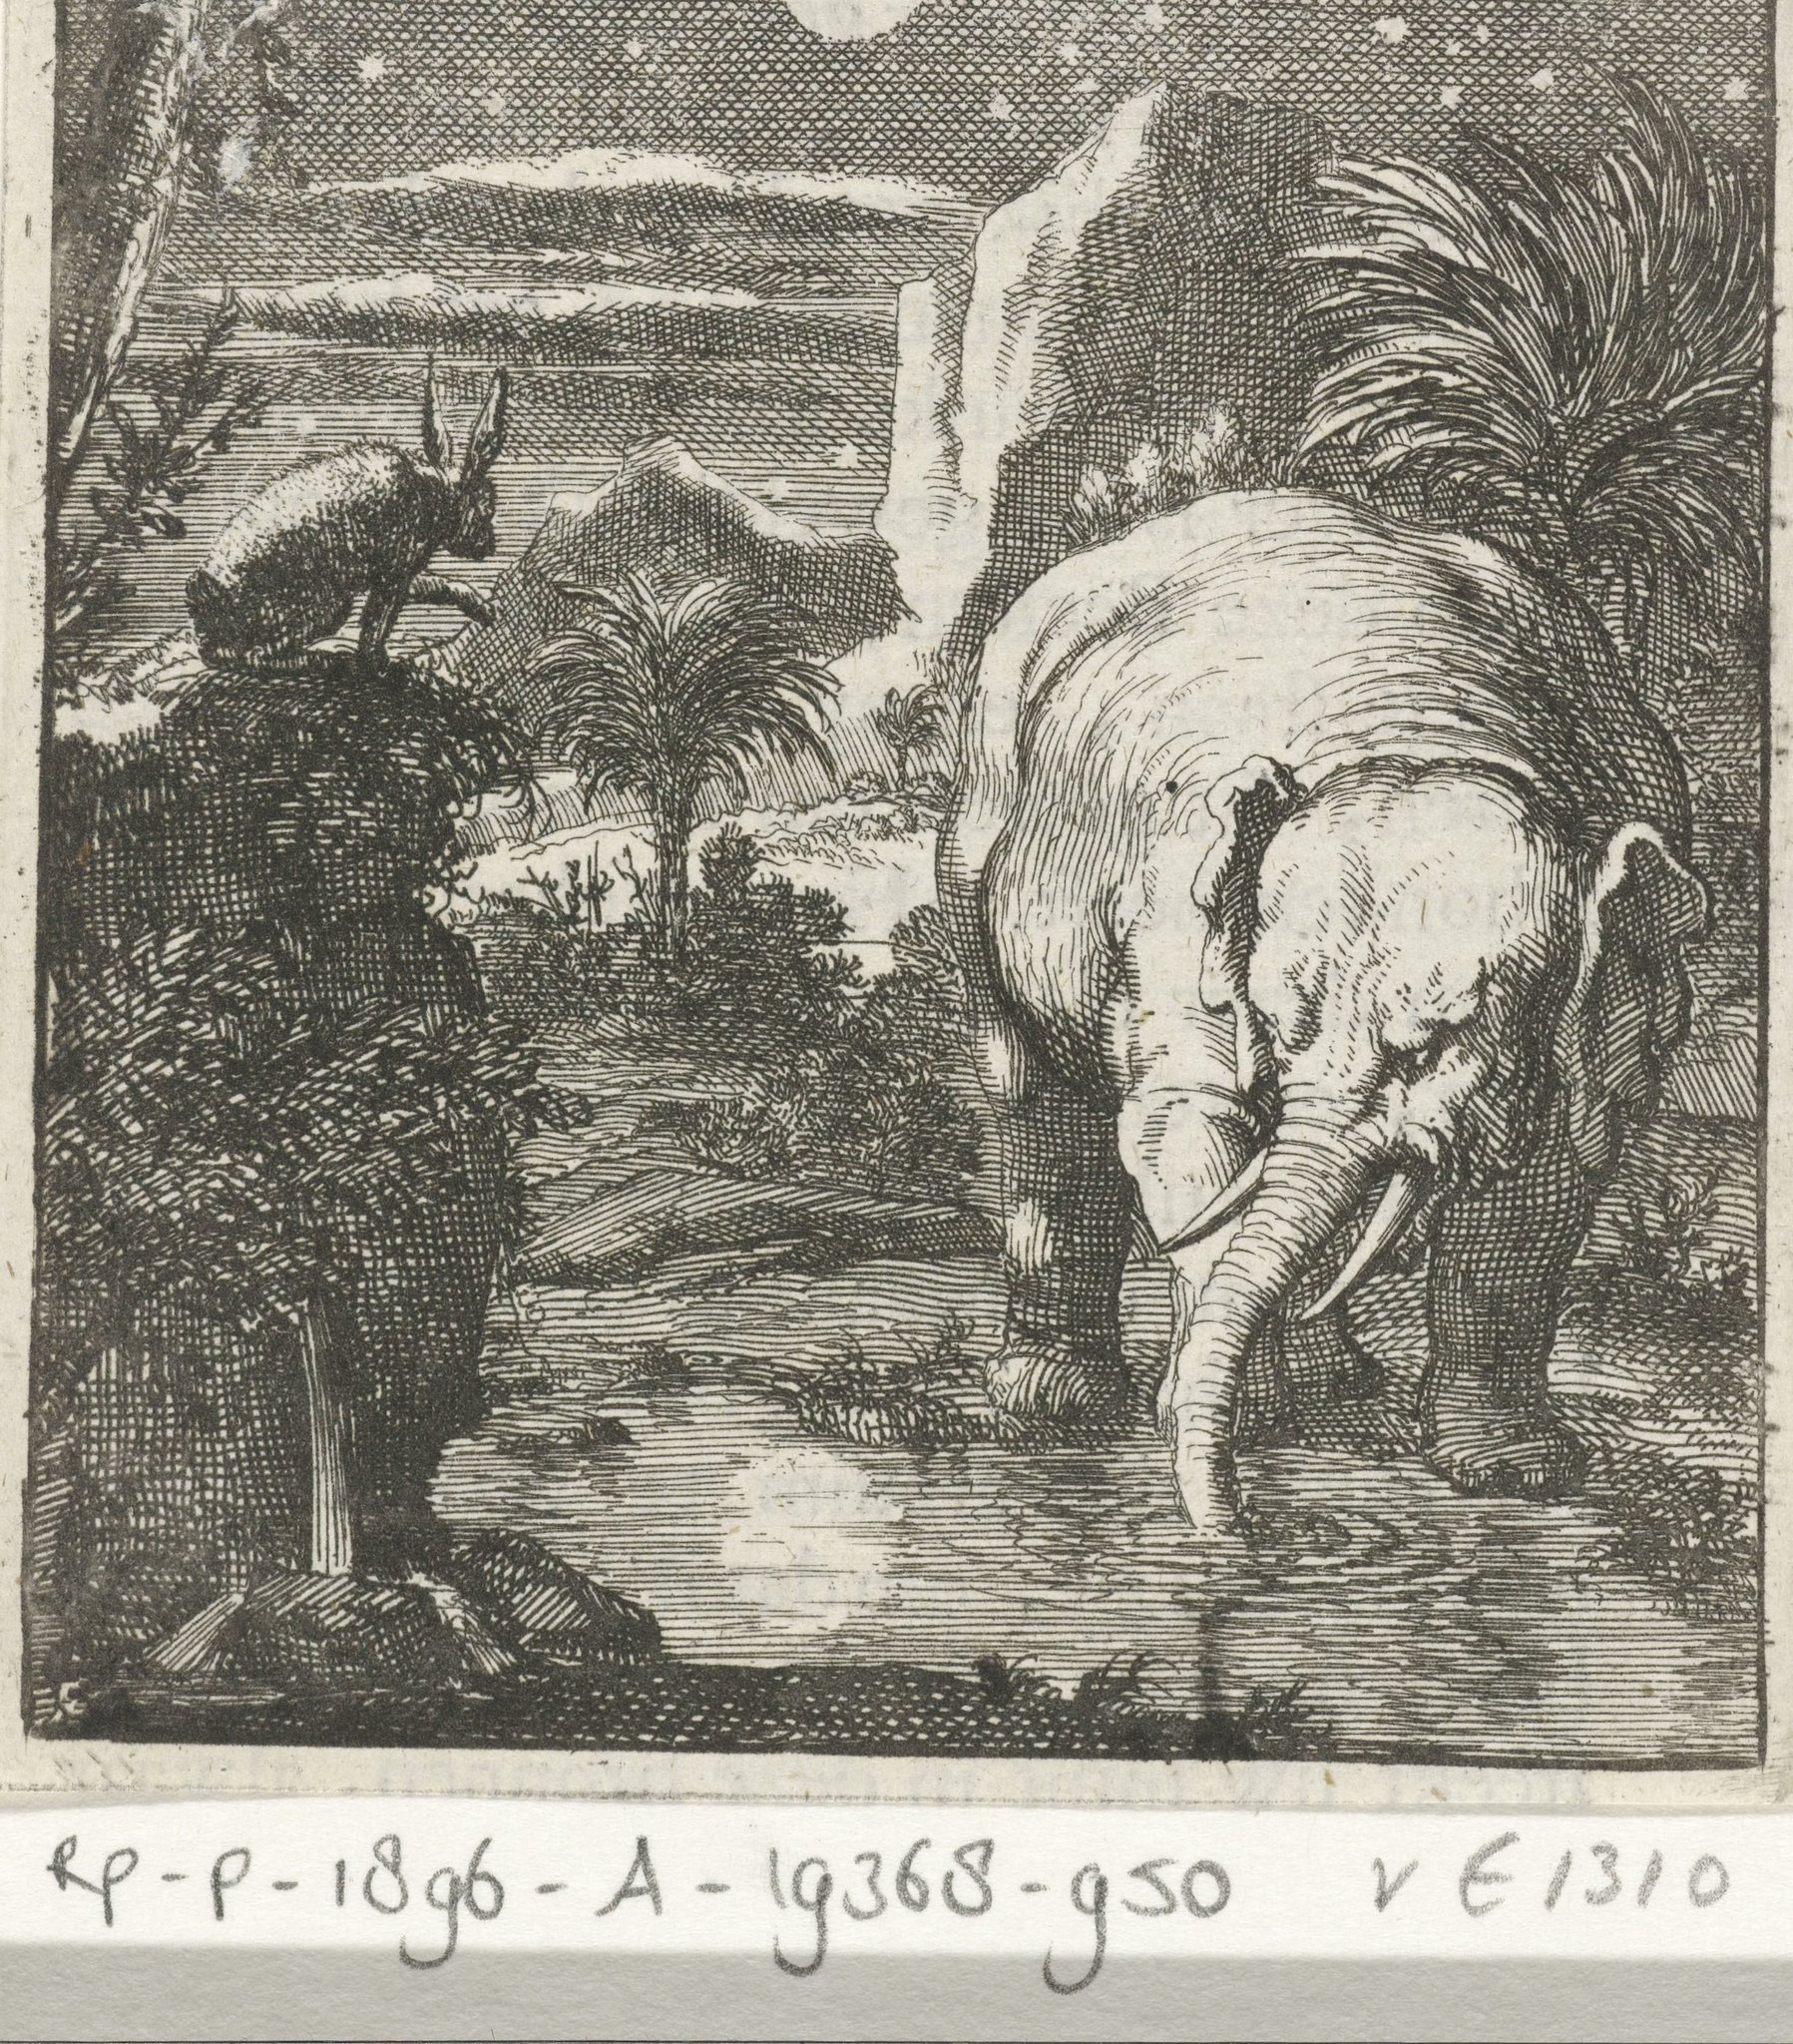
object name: print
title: Haas en olifant met volle maan bij een waterbron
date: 1693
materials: paper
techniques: etching, letterpress printing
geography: amsterdam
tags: full moon, rodents: hare, spring (fluids extracted from the earth), trunked animals: elephant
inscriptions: collector's mark: Lugt 2228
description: Illustratie uit: Duĳkerius, Johannes. Voorbeeldzels der oude wyzen. Waar in (...) de menschelijke hartstogten (...) behandeld worden. Amsterdam: Aart Wolsgrein, 1693, p. 281.